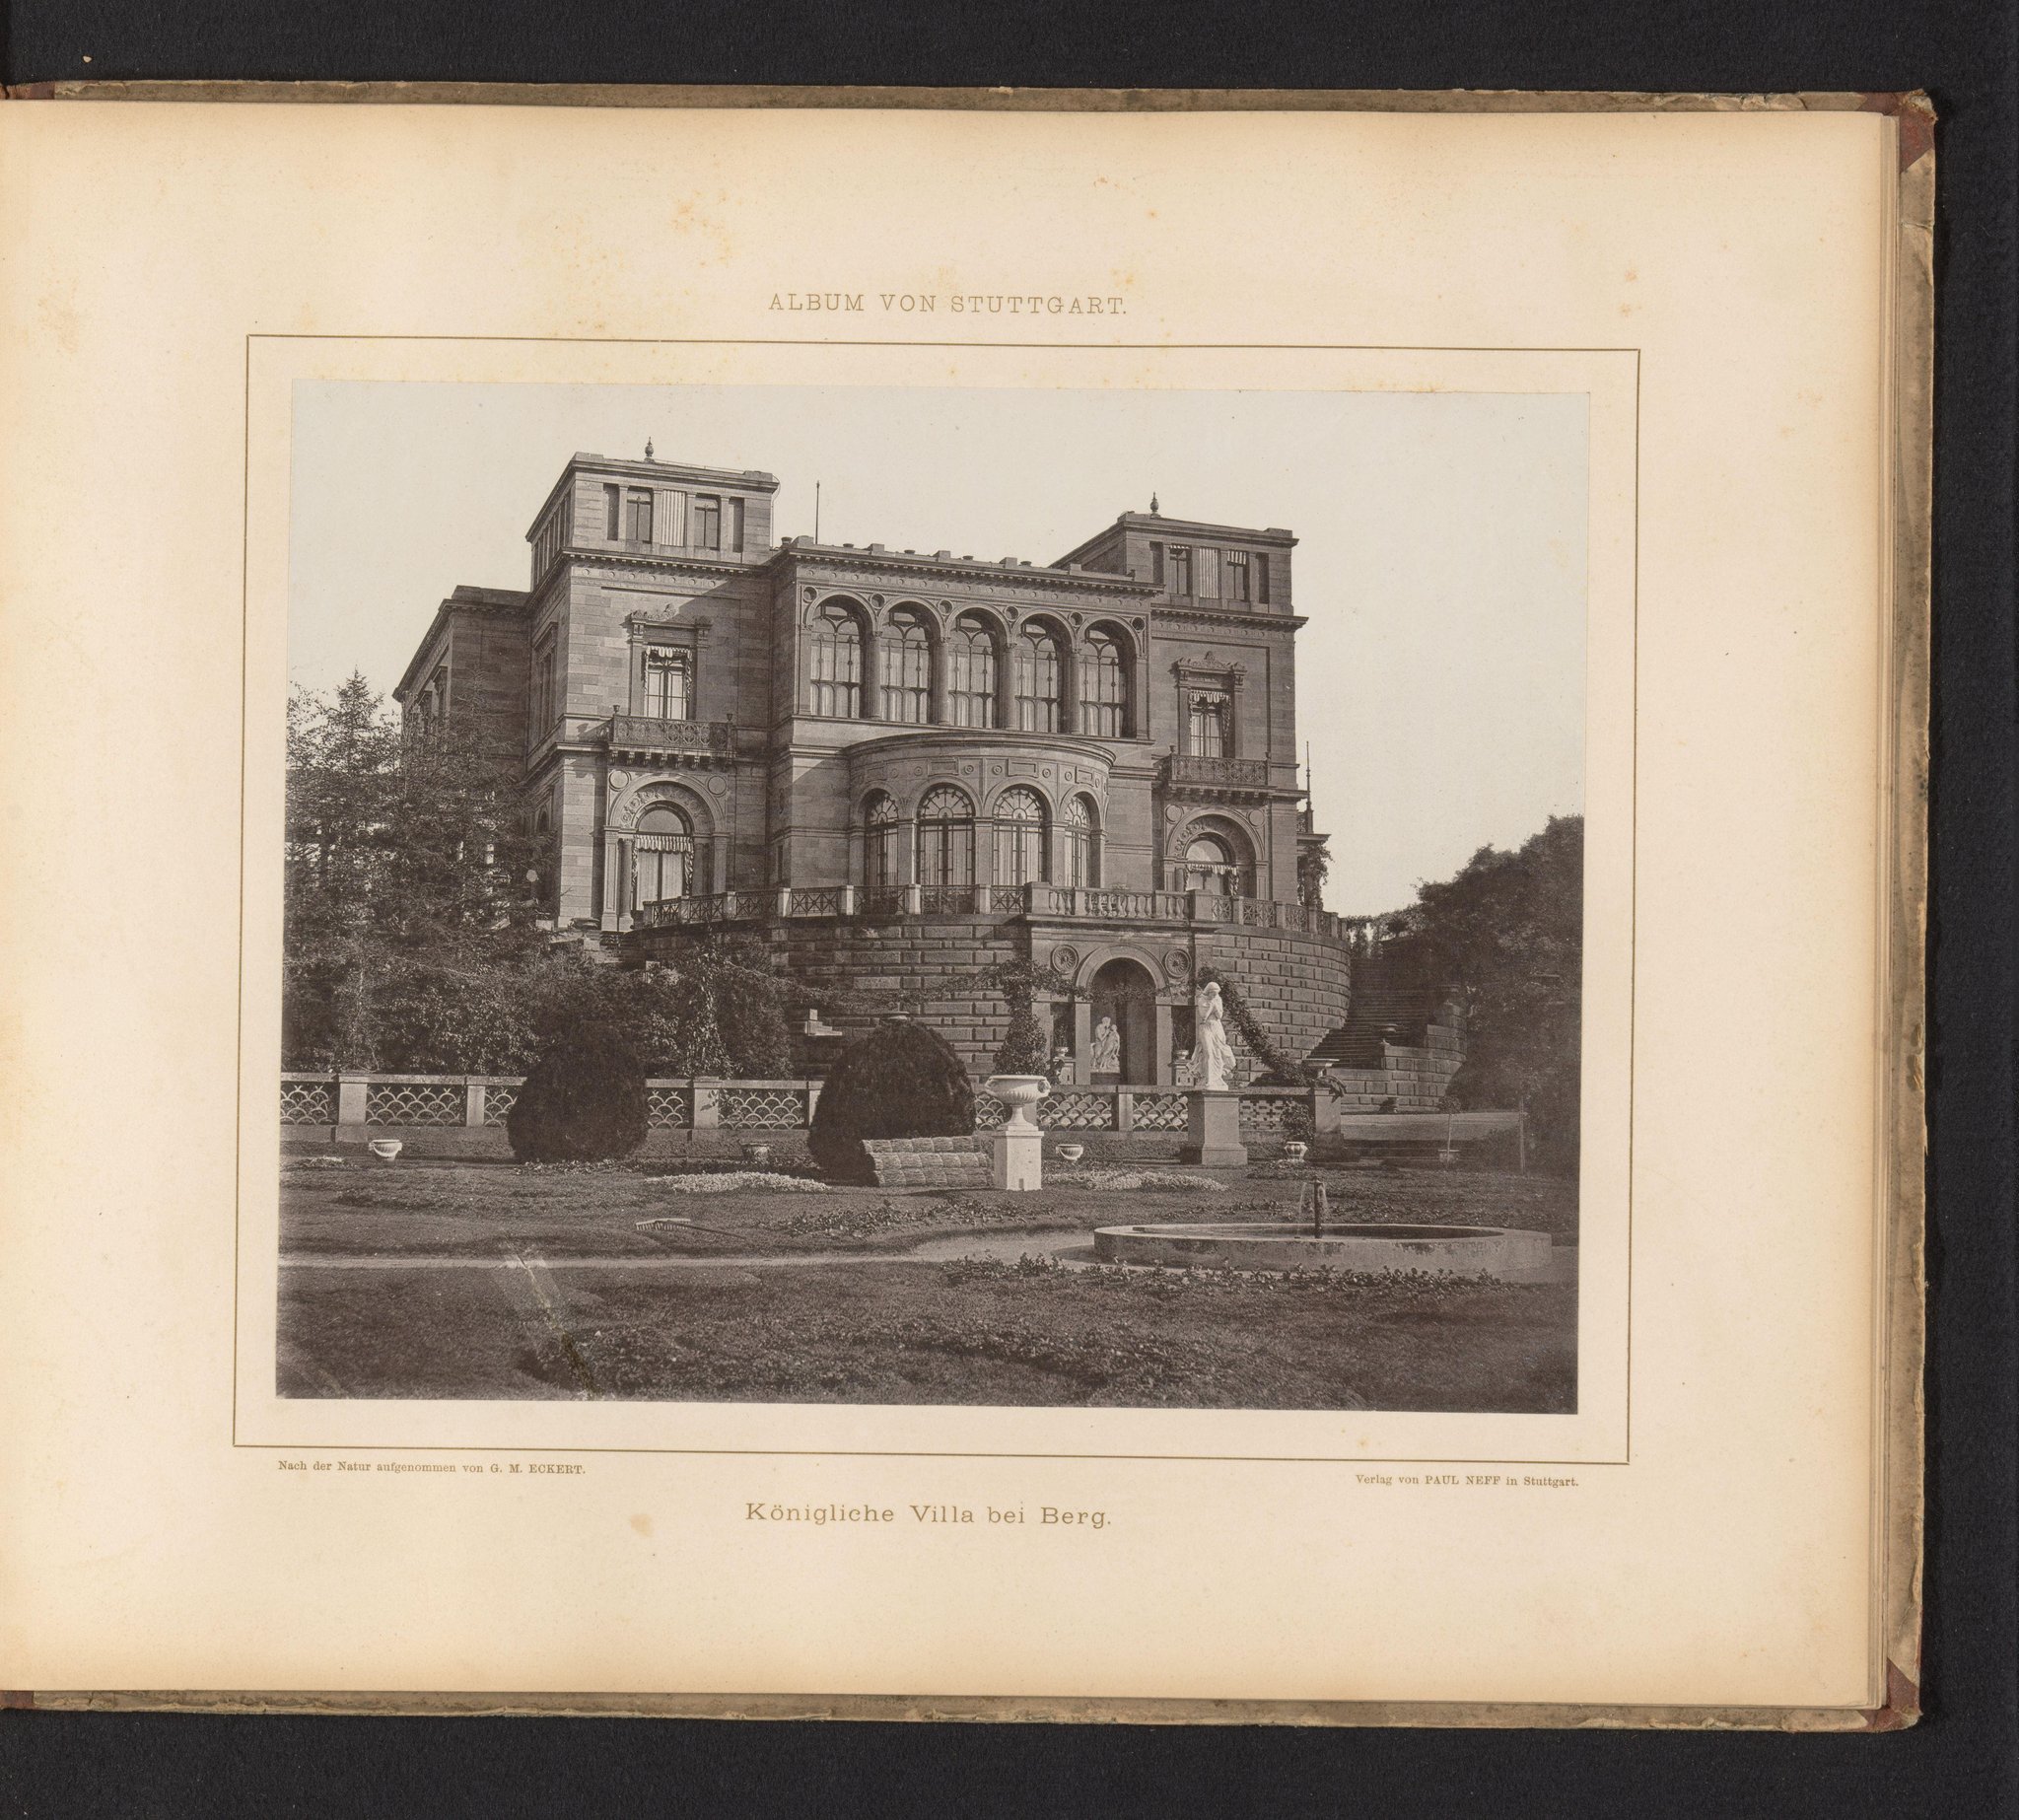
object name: page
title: Königliche Villa bei Berg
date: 1870-1875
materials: paper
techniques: photograph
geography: stuttgart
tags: villa